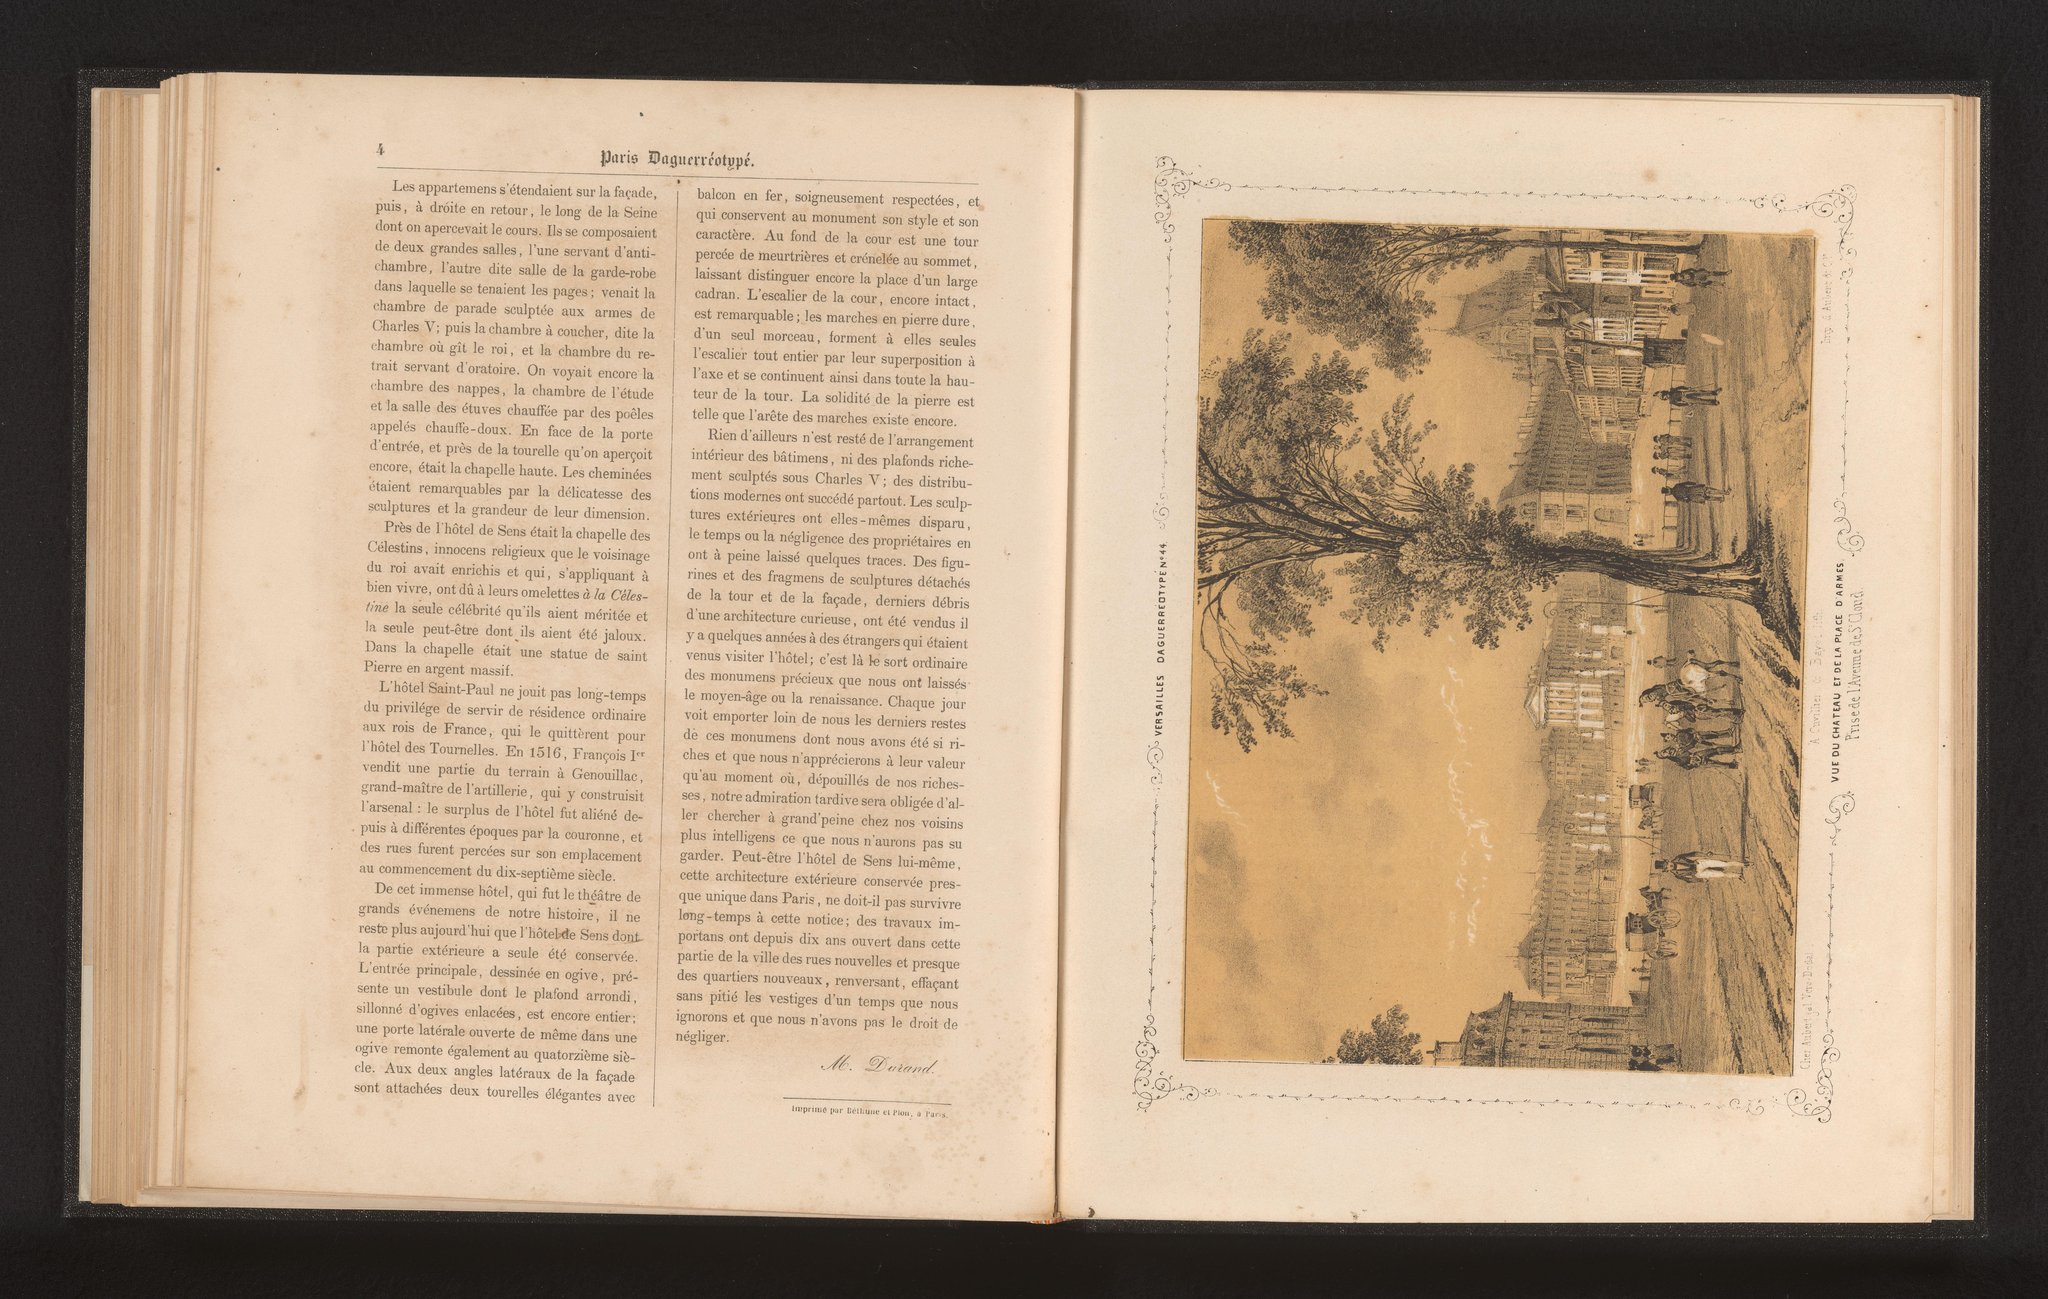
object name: page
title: Place d'Armes in Versailles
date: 1839-1840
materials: paper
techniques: tone lithography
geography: paris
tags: square, place, circus, etc.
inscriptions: inscription: ‘VERSAILLES DAGUERRÉOTYPÉ No. 44.’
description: Prent op honderdvijfenzeventigste ongenummerde pagina.